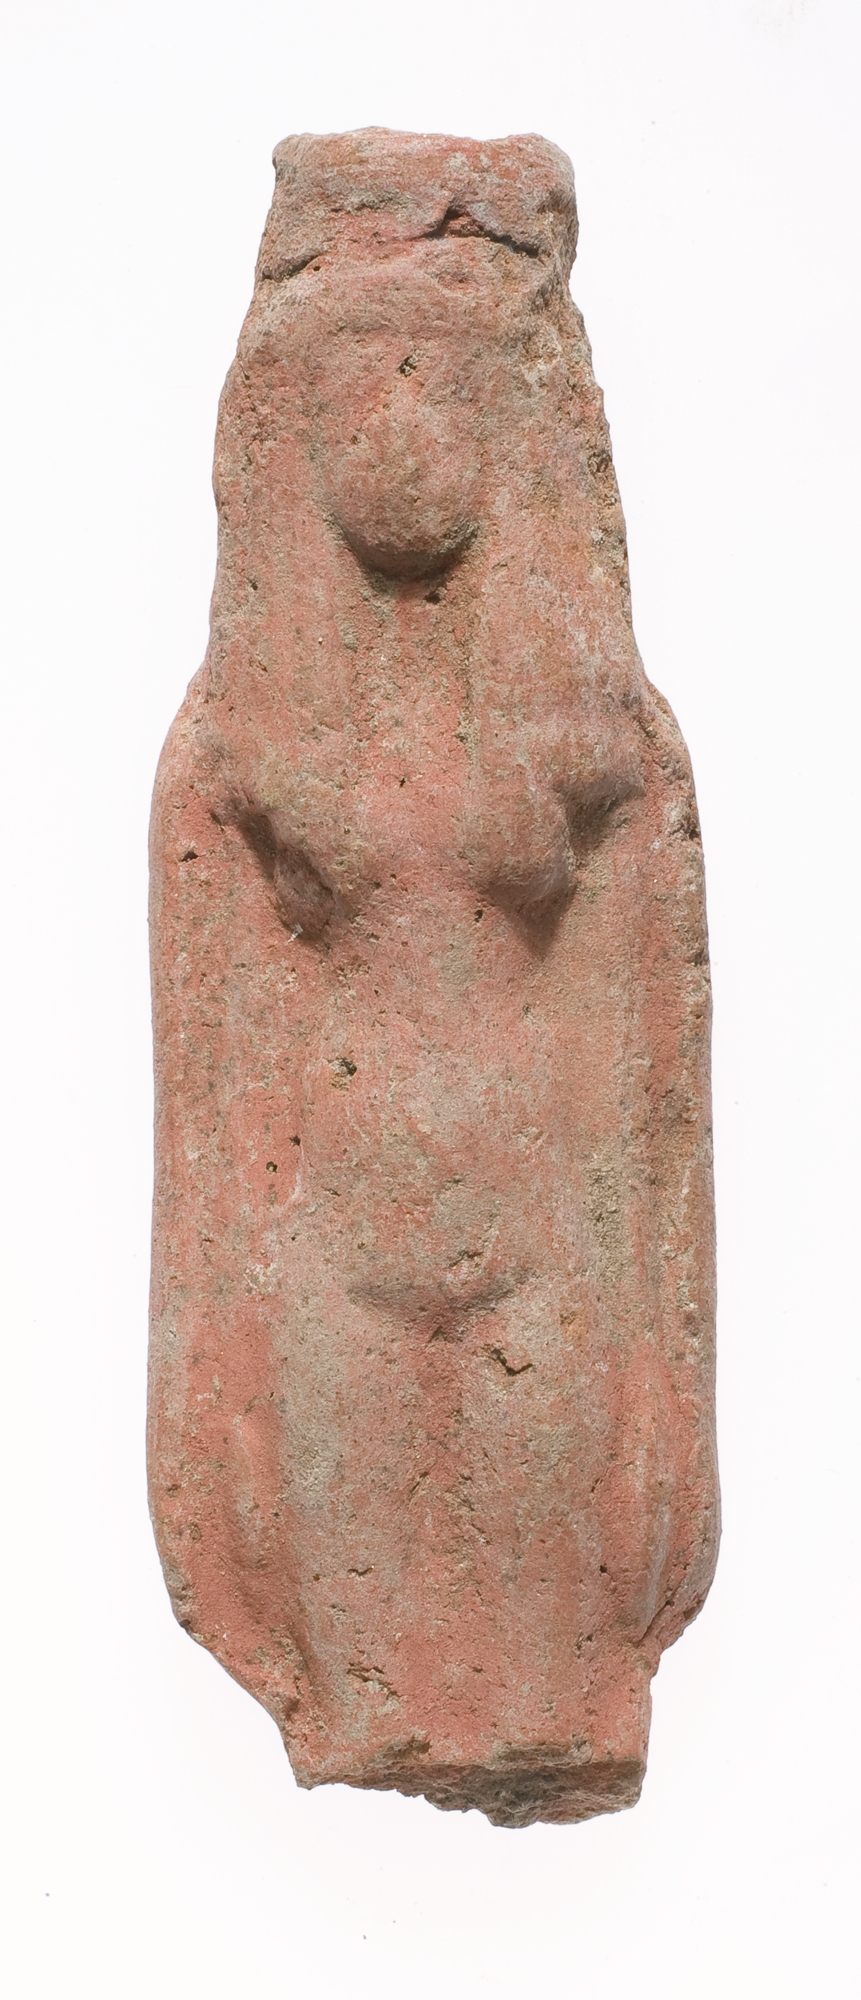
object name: statuette of a woman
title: Standing female figurine square headdress, missing most of her legs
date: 1390-1186 BCE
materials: pottery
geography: egypt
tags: women